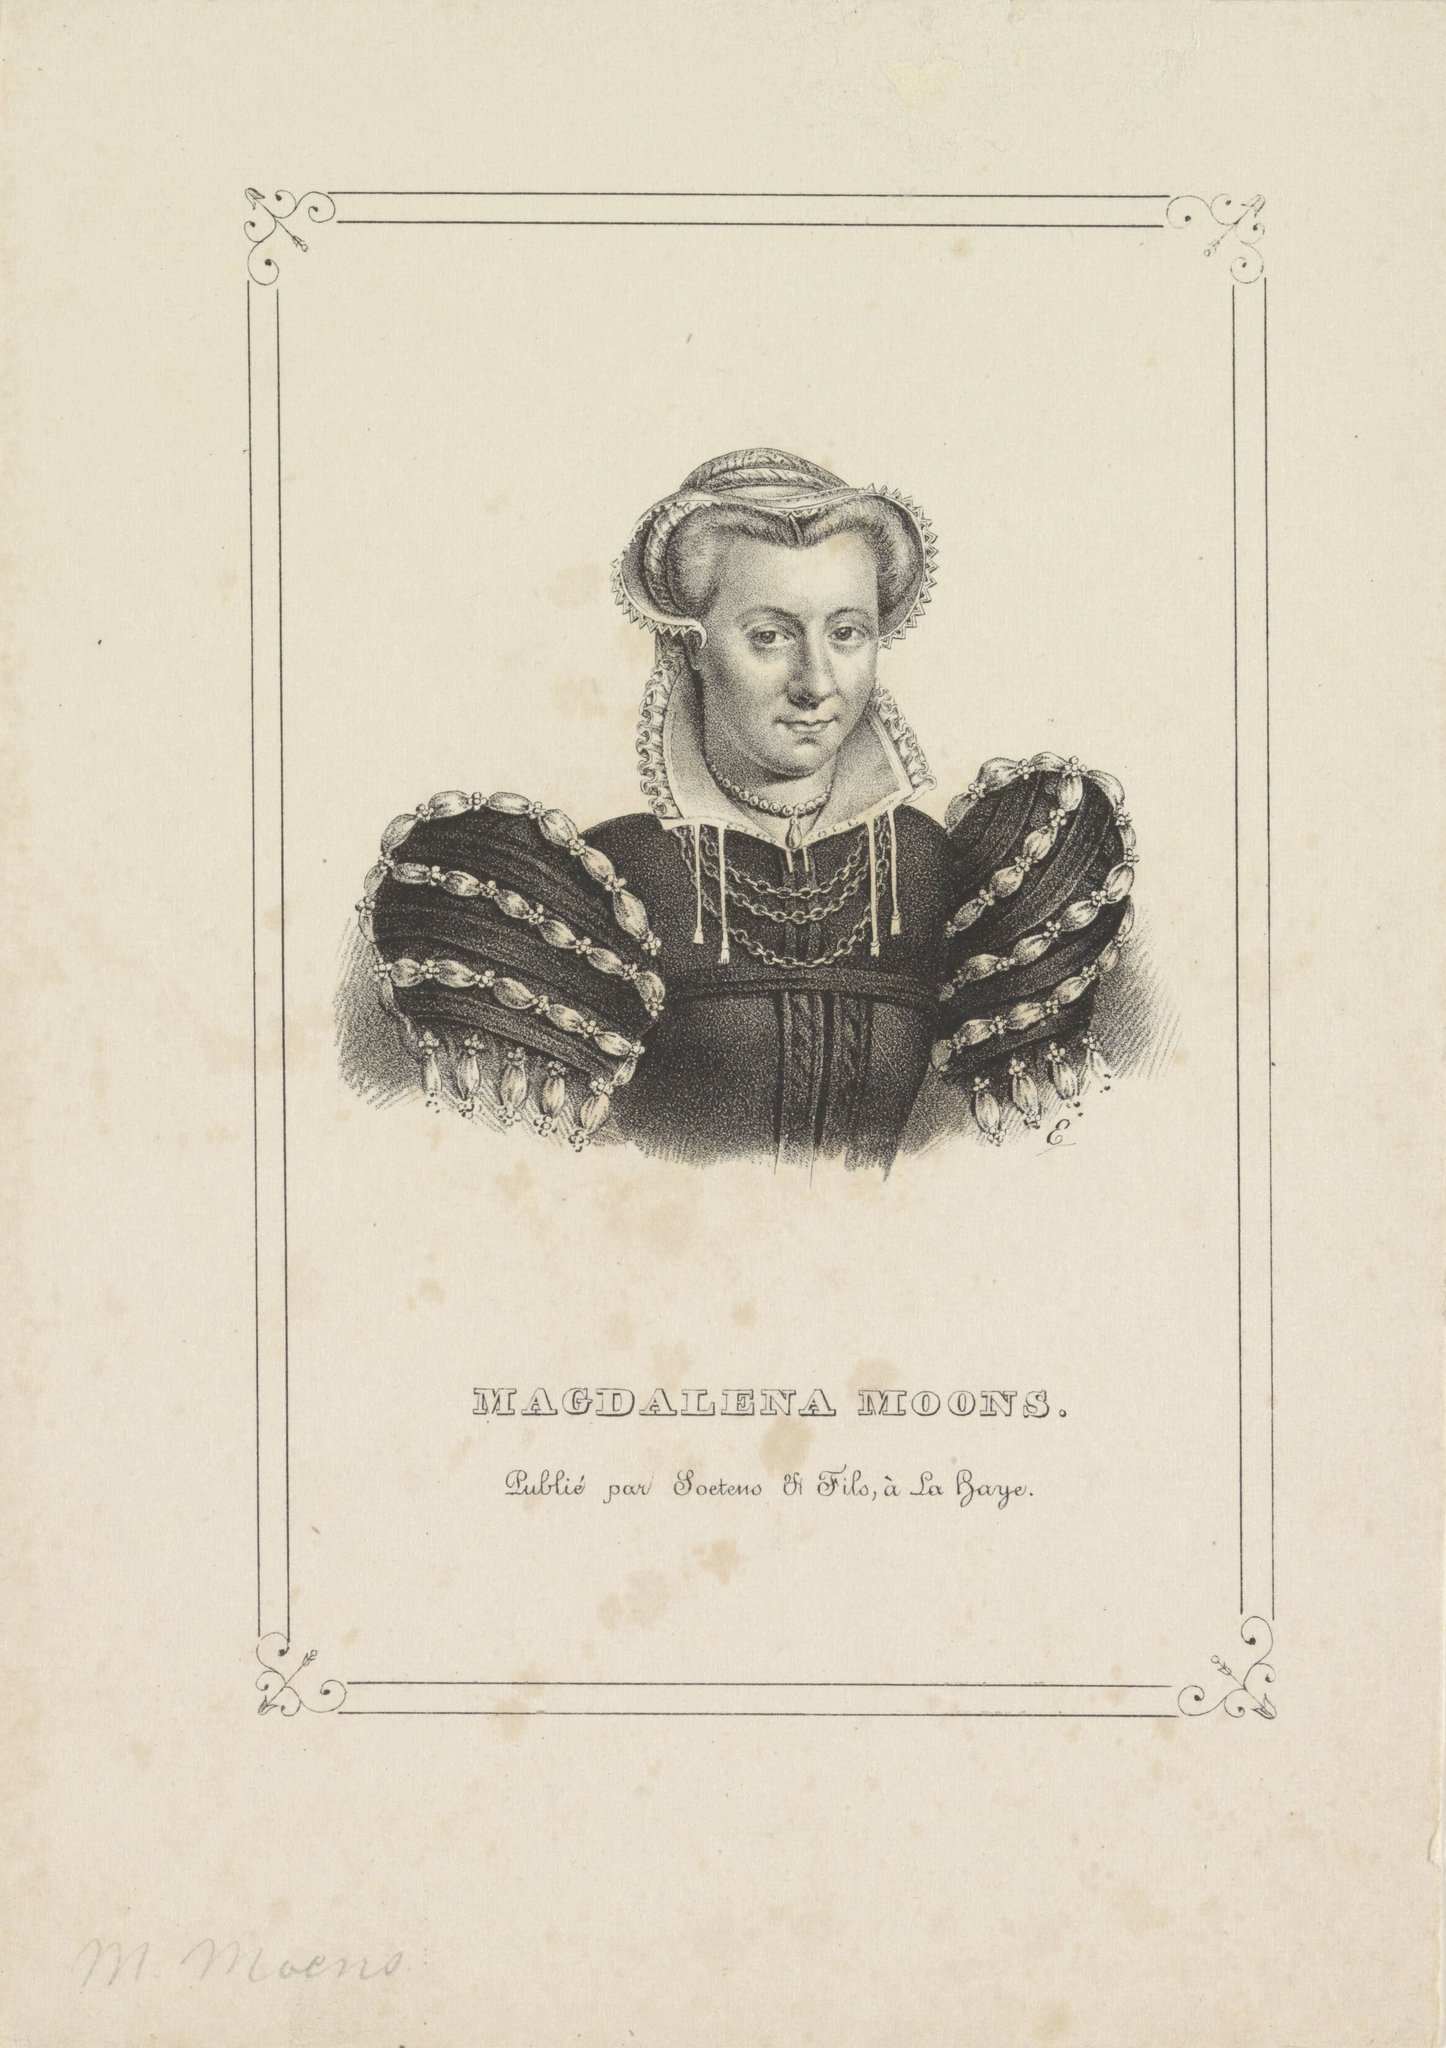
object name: print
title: Portret van Magdalena Moons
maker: gerhardus fredericus eilbracht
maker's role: draughtsman, print maker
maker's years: 1816-1854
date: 1837-1840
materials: paper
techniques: lithograph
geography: the hague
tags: the hague, utrecht, historical persons (+ (full) bust portrait)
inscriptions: collector's mark: Lugt 2228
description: Deze prent maakte deel uit van een serie uitgegeven door Soetens et Fils omstreeks 1838, opgedragen aan de Prins van Oranje. In de 'Prospectus en Inteekenlijst' stond vermeld dat het zal bestaan uit een onbepaald aantal portretten, waarvan er drie of vier per maand verschijnen. Zie Van Someren.